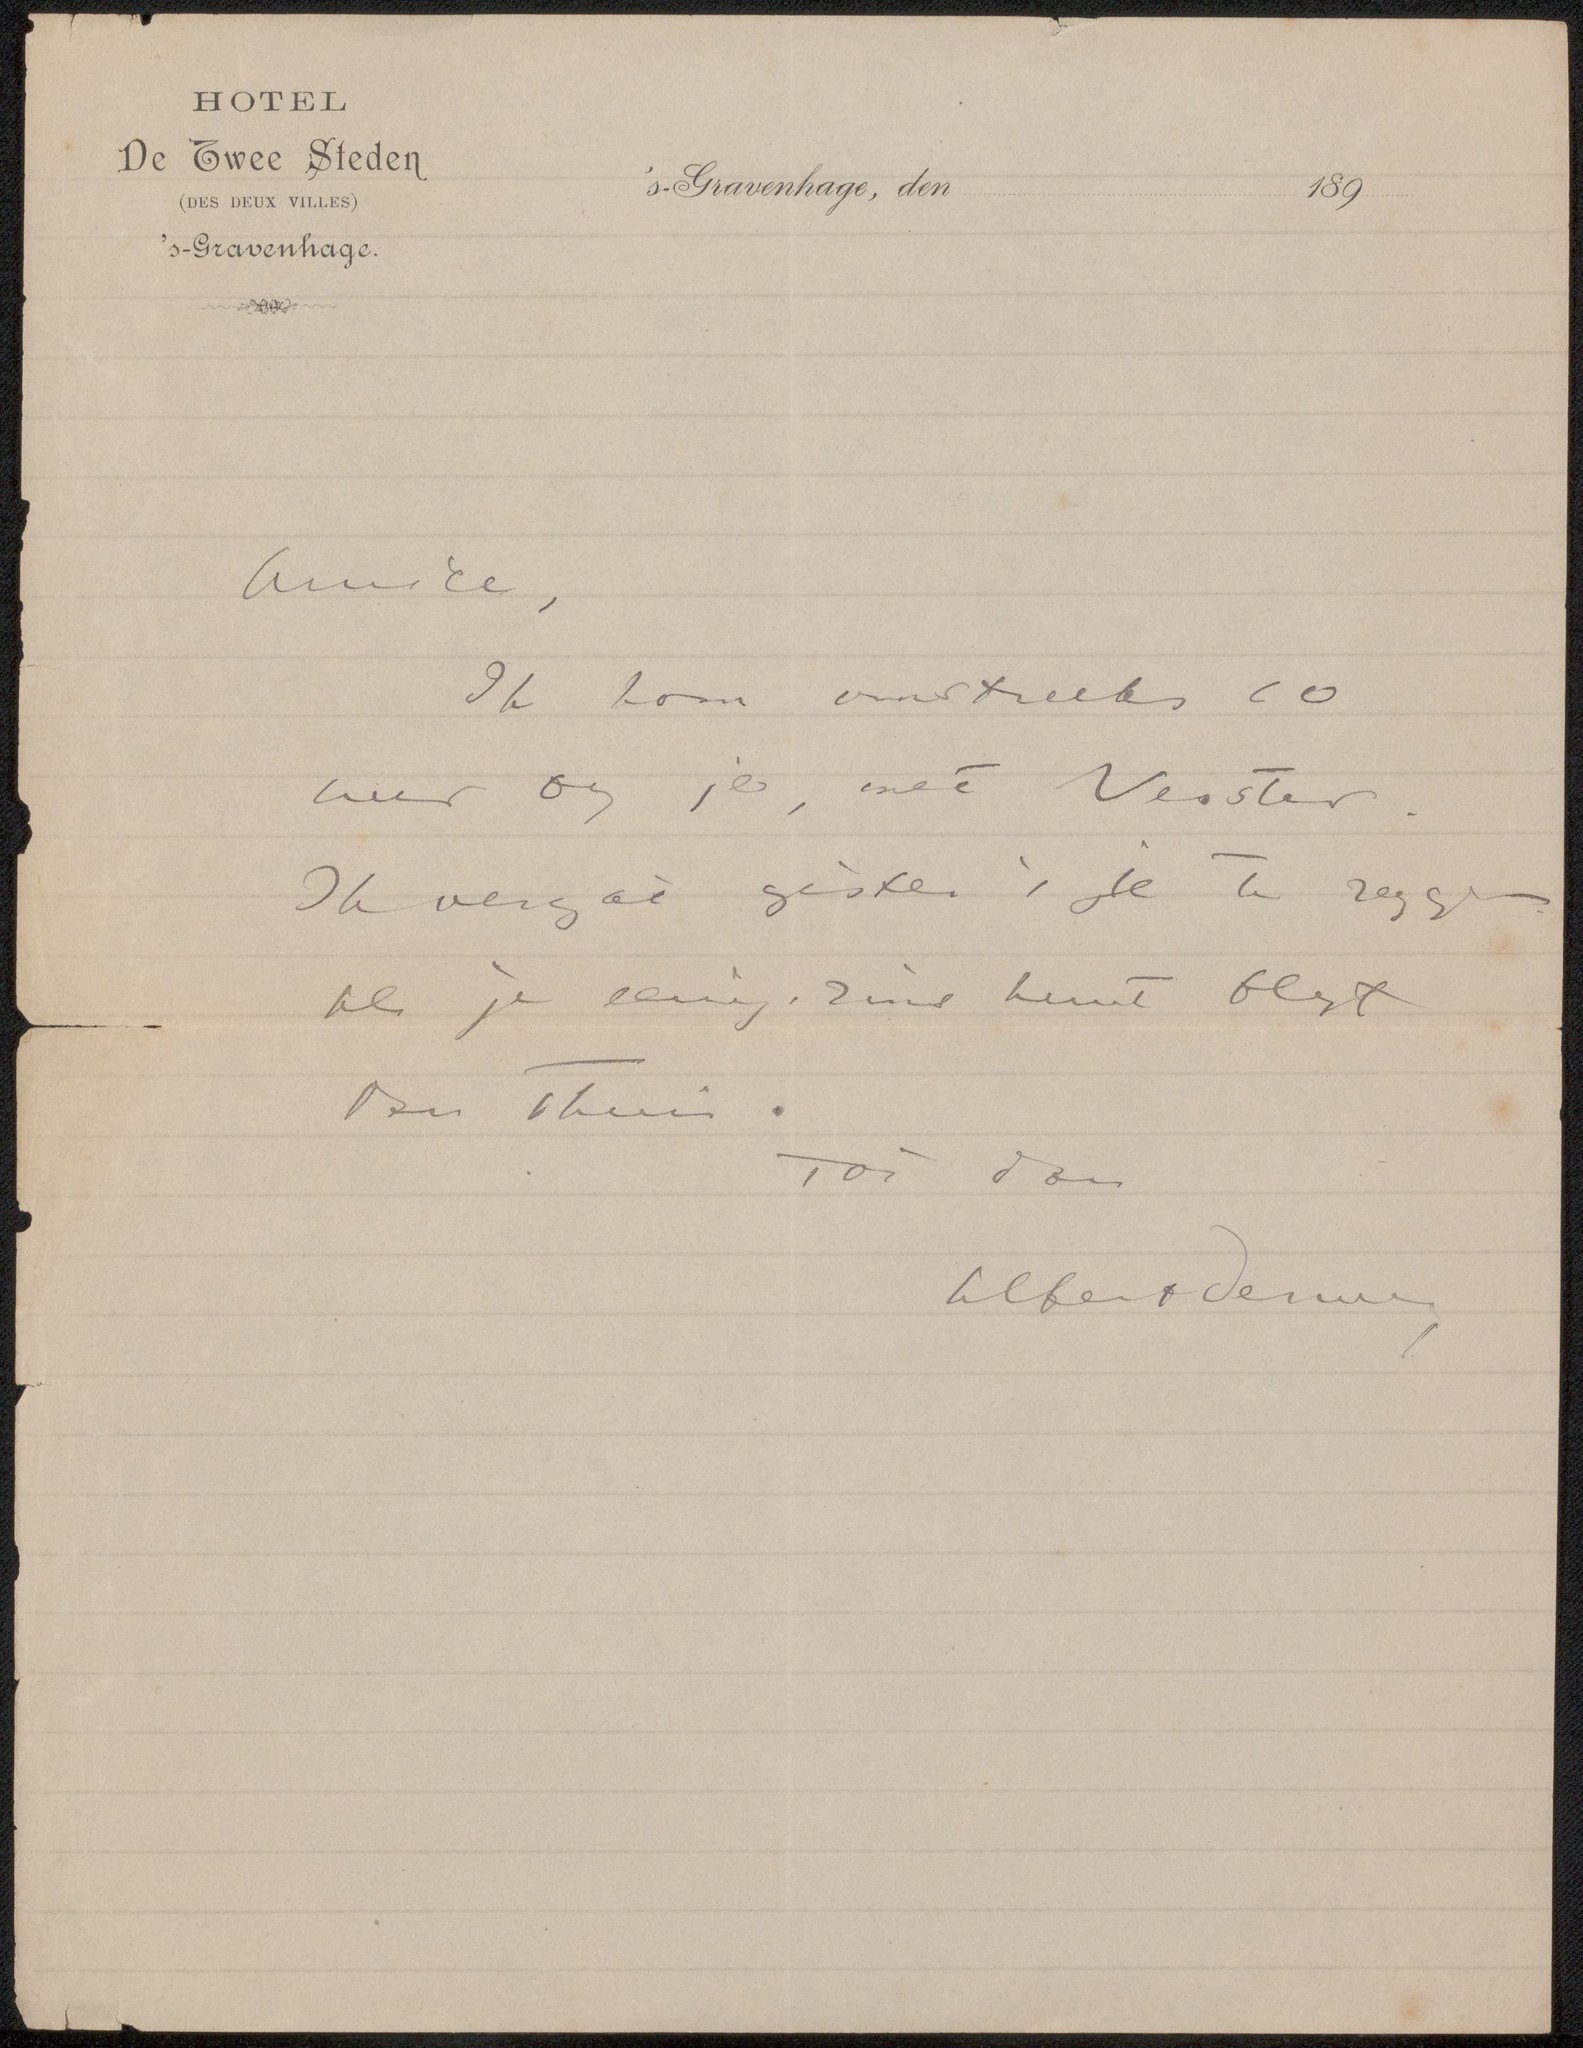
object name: letter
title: Brief aan Philip Zilcken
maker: albert verwey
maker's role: criticus, dichter, essayist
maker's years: 1865-1937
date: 1890-1930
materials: ink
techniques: pen, printing, writing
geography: the hague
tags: leiden, painter, print maker, draughtsman, floris verster, philip zilcken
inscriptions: collector's mark: ‘RPK’